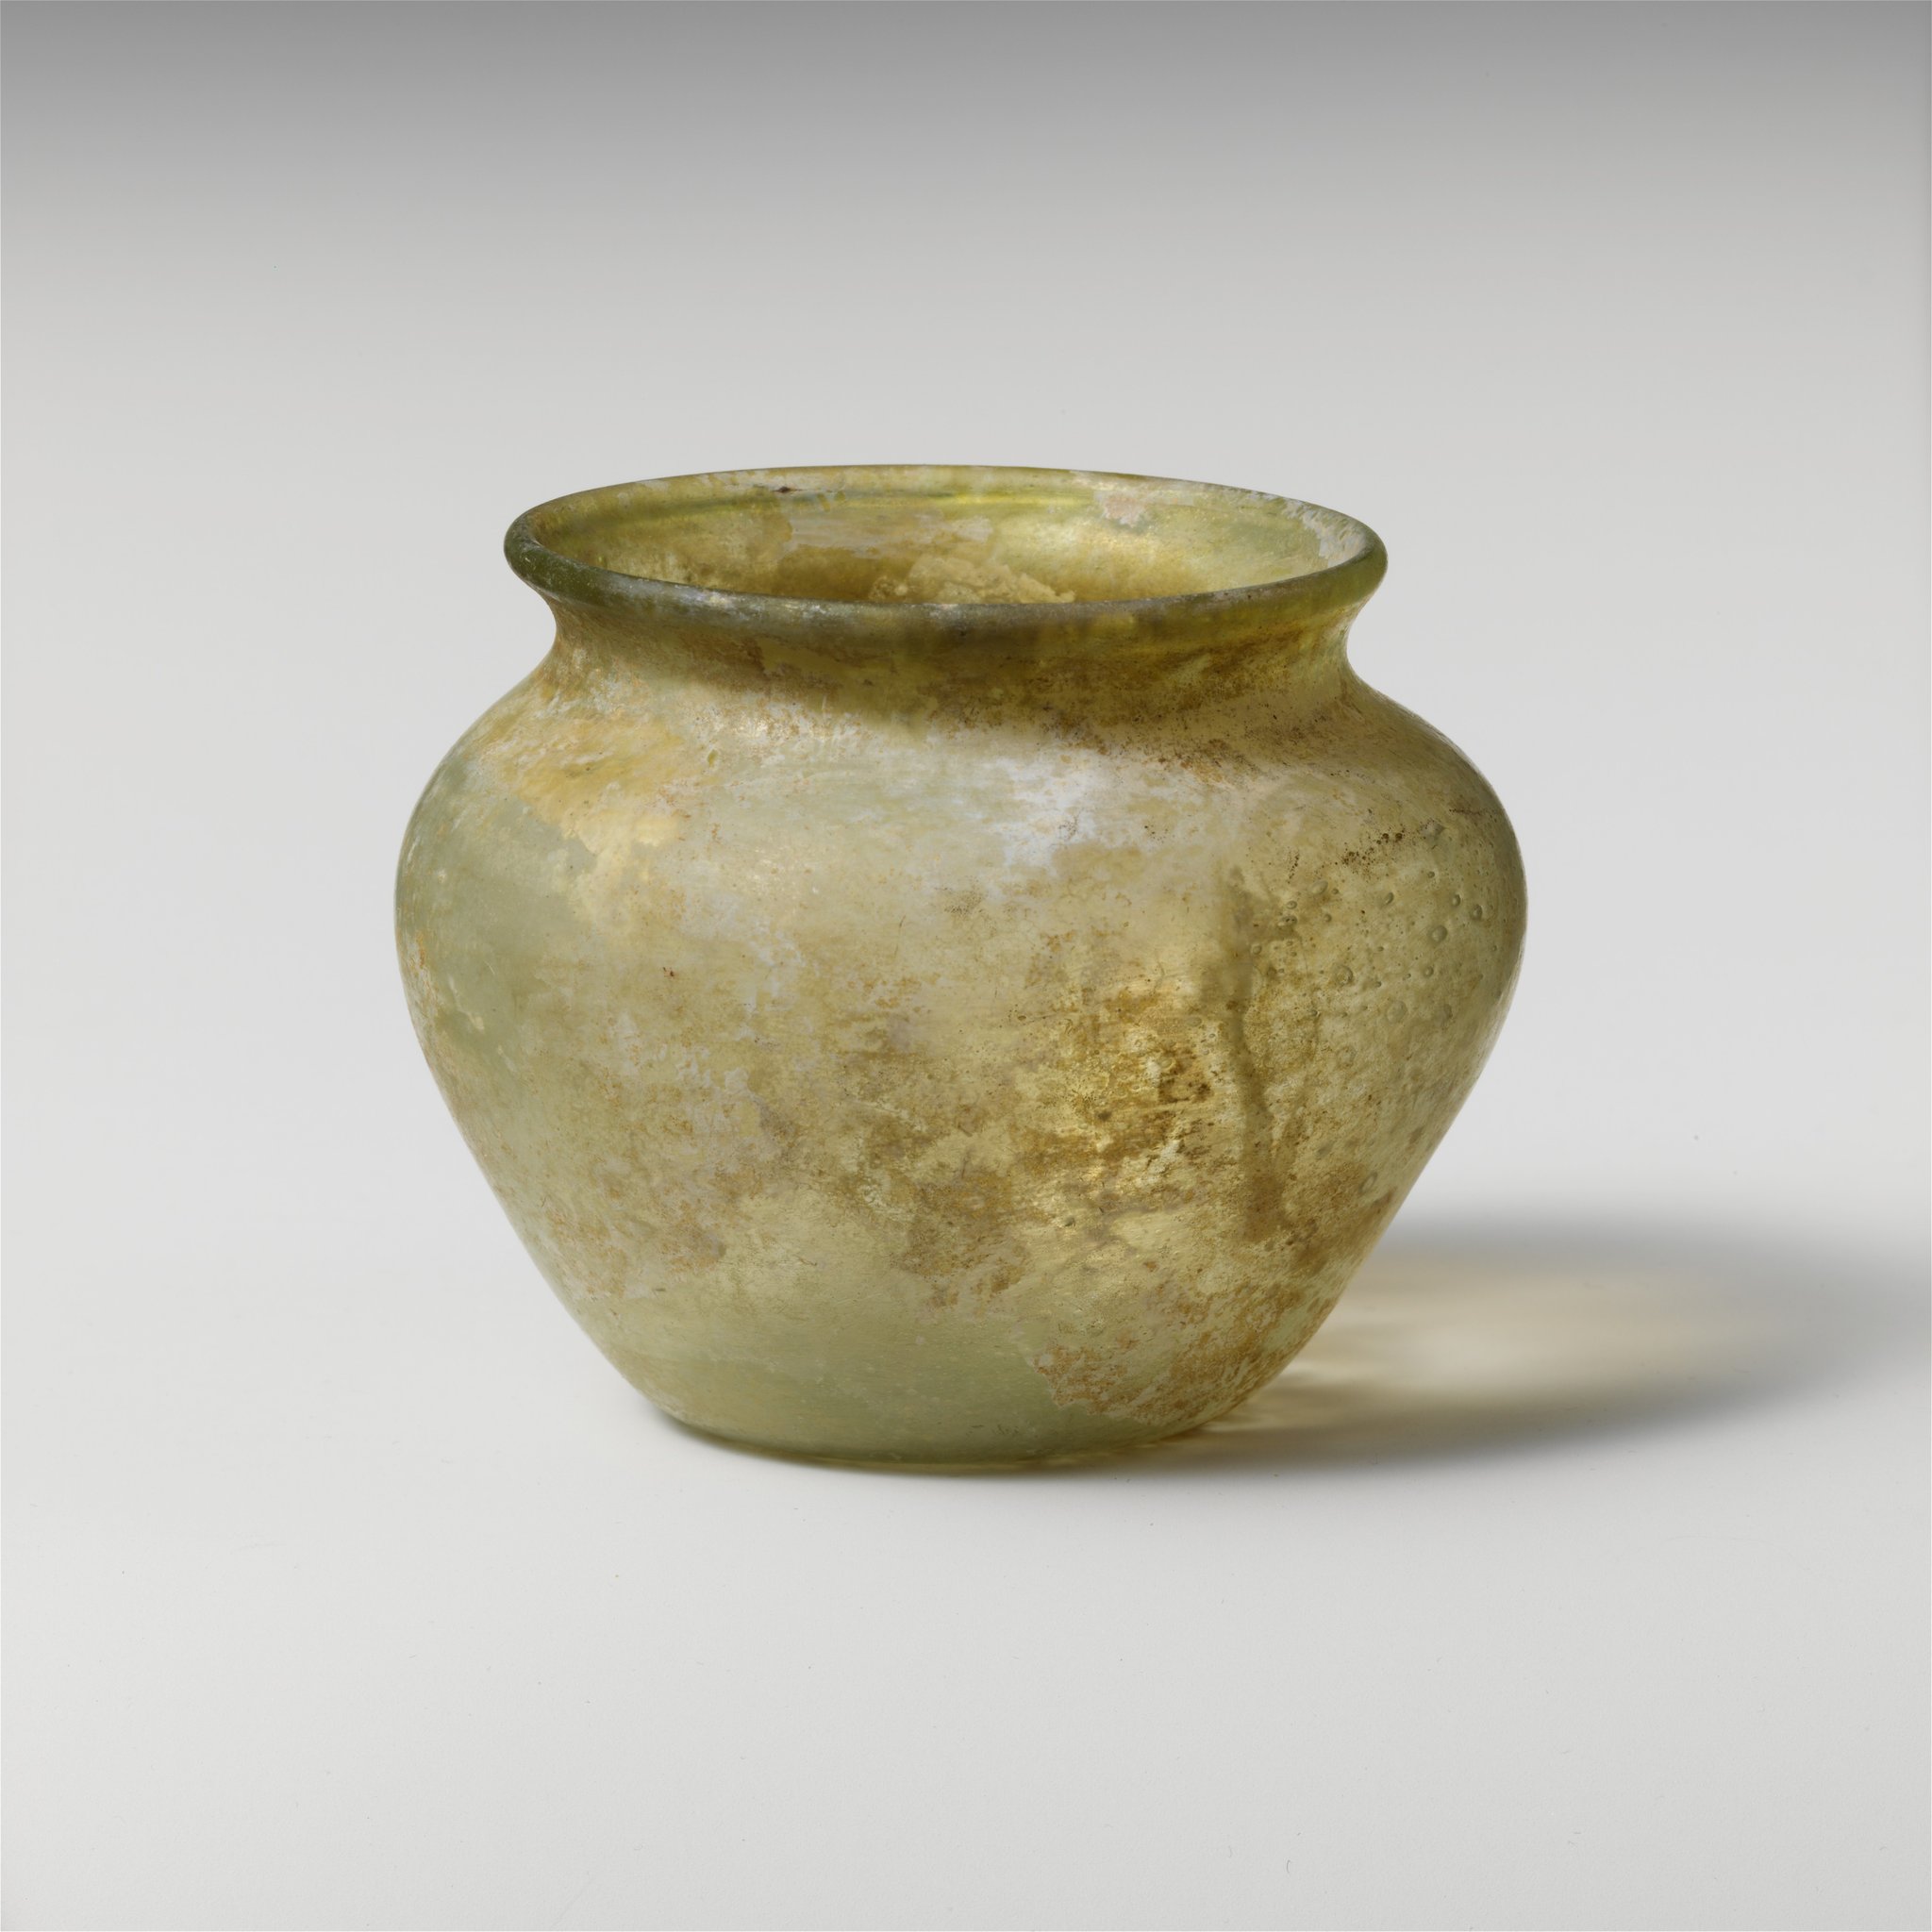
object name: jar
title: Glass jar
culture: roman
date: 101-300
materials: glass